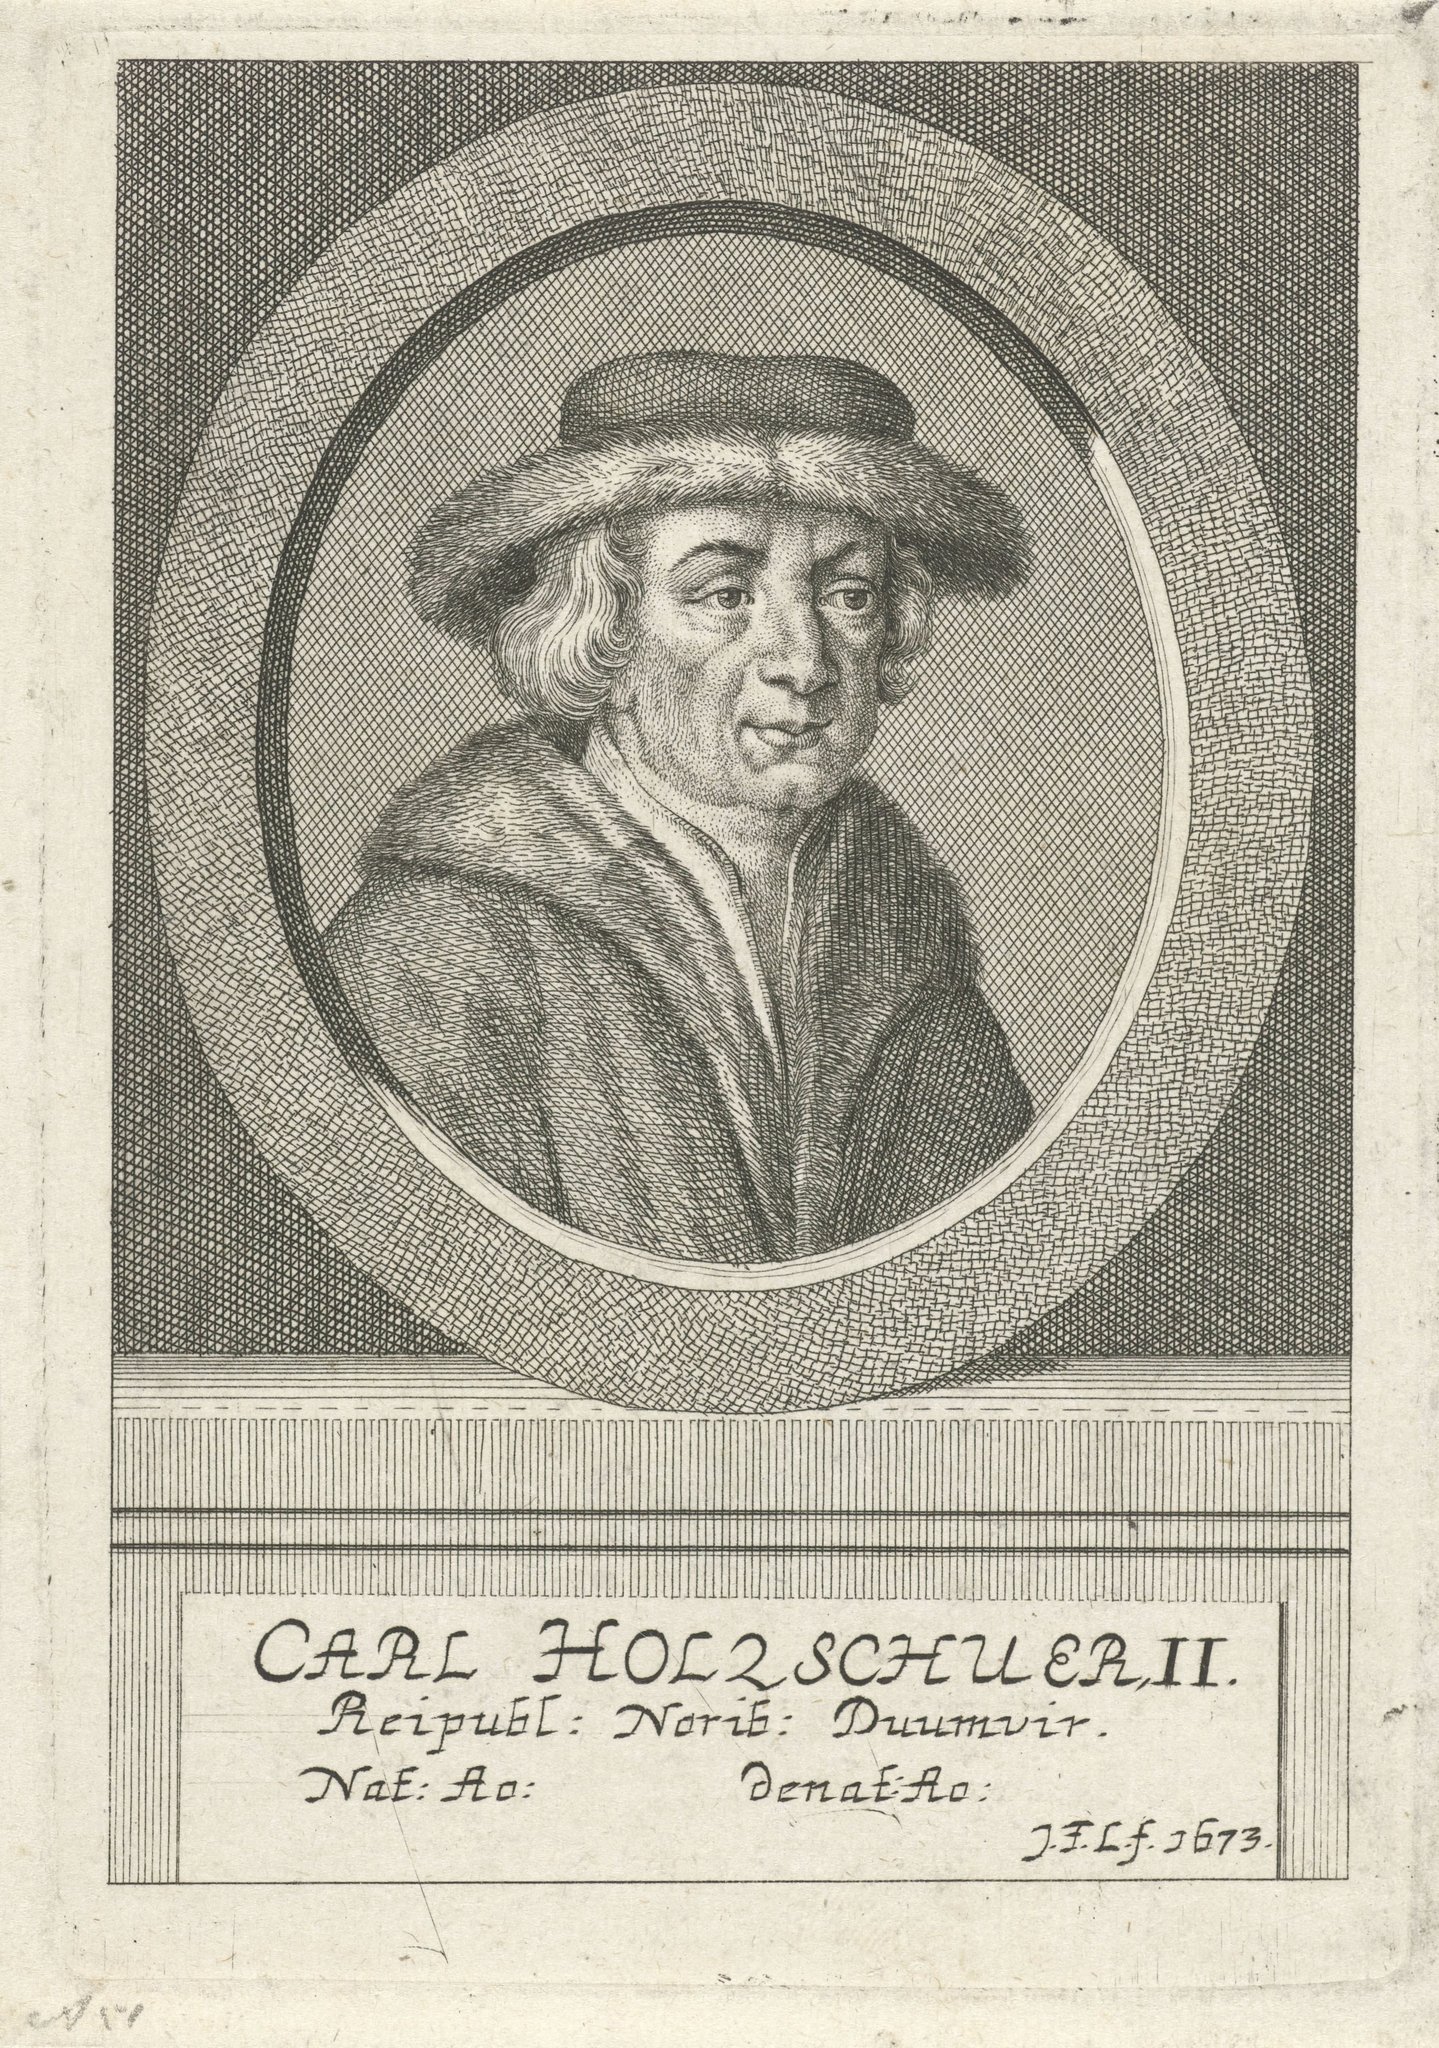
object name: print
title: Portret van Carl II Holzschuer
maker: johann friedrich leonard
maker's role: print maker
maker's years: 1633-1680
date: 1673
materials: paper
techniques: engraving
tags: carl ii holzschuer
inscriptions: collector's mark: Lugt 2228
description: Portret van Carl II Holzschuer, magistraat te Neurenberg.